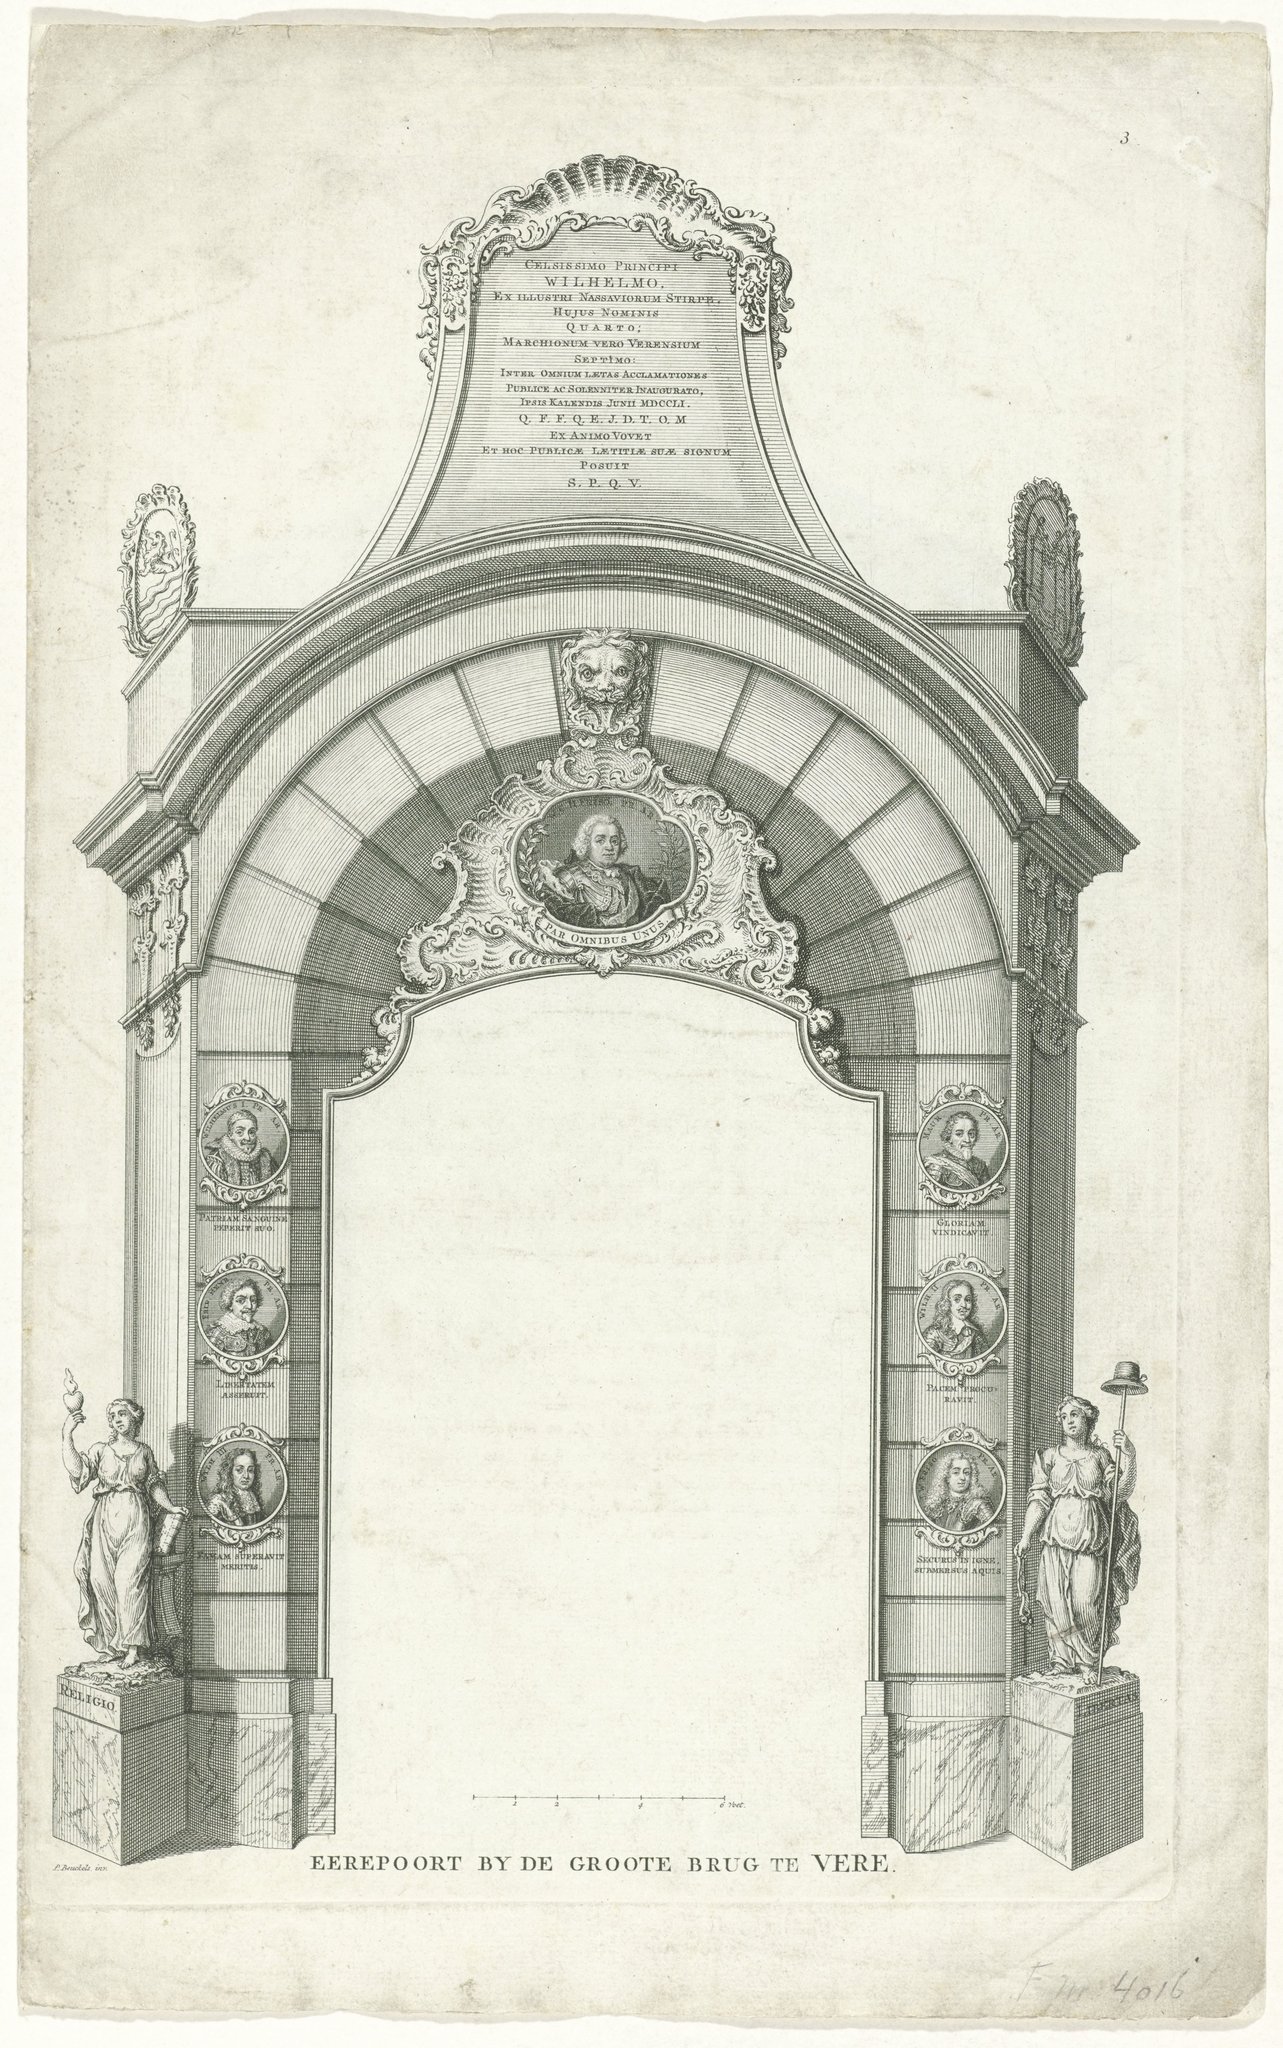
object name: print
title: Erepoort bij de Grote Brug, 1751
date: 1751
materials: paper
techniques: etching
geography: veere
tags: the hague, willem iv (prins van oranje-nassau), triumphal arch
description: Dubbelgevouwen blad. Genummerd rechtsboven: 3. De erepoort geplaatst bij de Grote Brug. Op de boog portretten van stadhouder Willem IV en zijn voorgangers, met standbeelden van Godsdienst en Vrijheid. Onderdeel van de illustraties van de feestelijke inhuldiging van stadhouder Willem IV als markgraaf van Veere op 1 juni 1751.